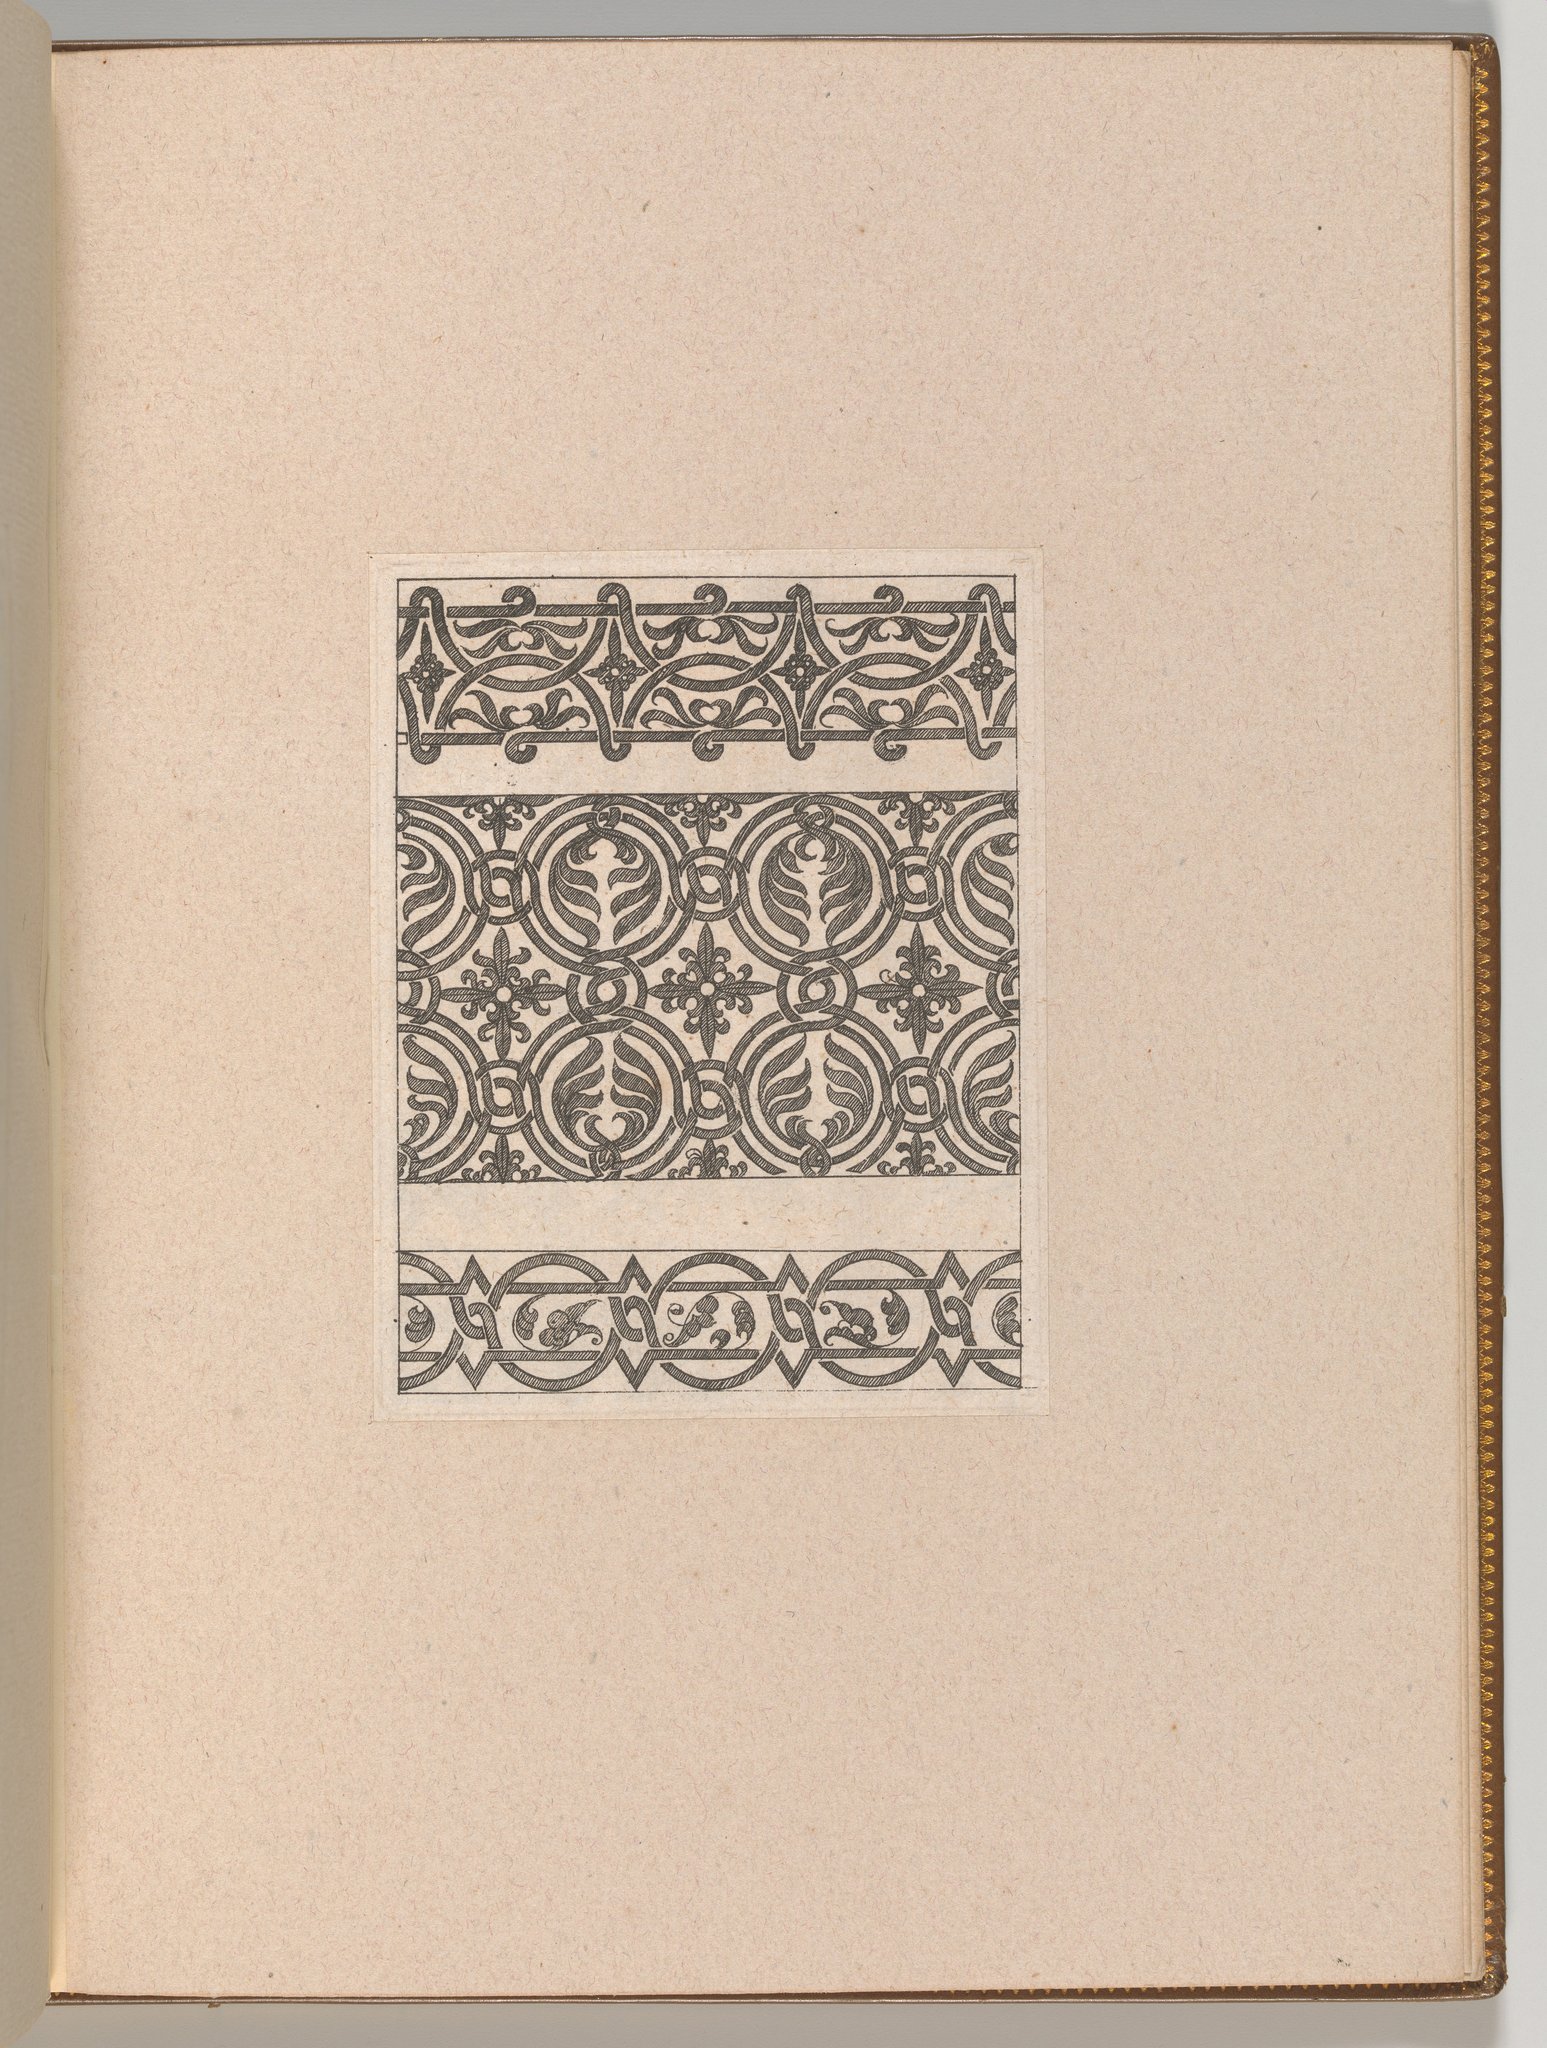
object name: album print ornament architecture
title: Copies after the 'Livre contenant passement de moresques' (plate 15)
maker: jacques androuet du cerceau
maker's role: artist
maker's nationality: french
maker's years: 1510-1585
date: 1801-1900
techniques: etching